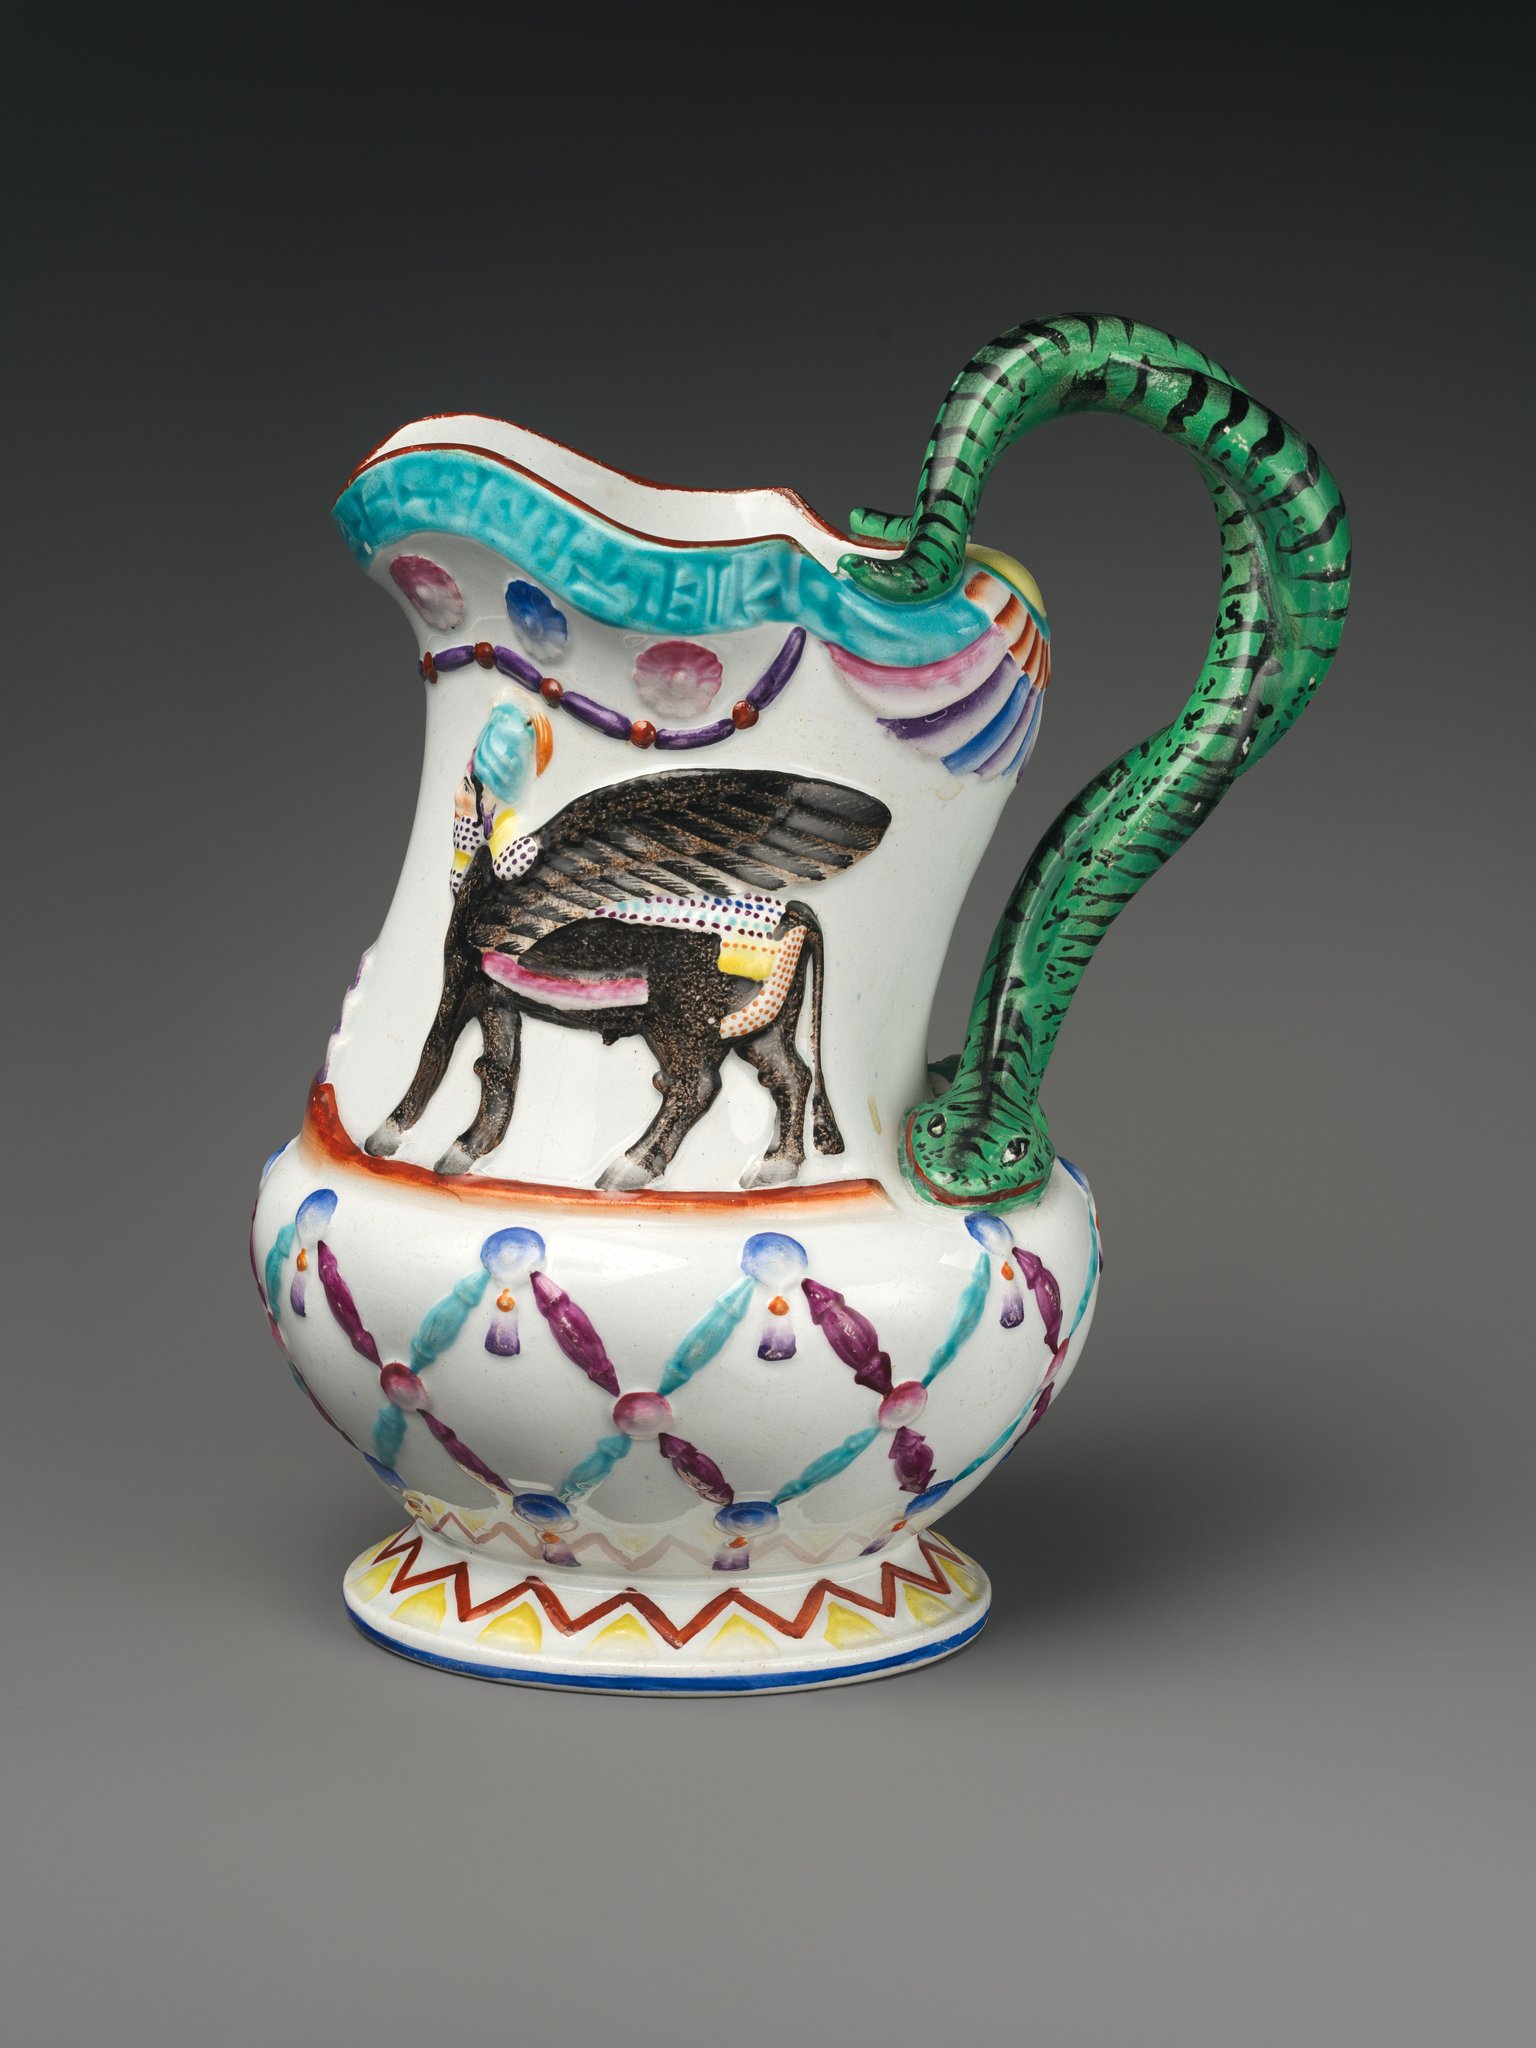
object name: jug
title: Jug with Assyrian-inspired decoration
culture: british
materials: porcelain